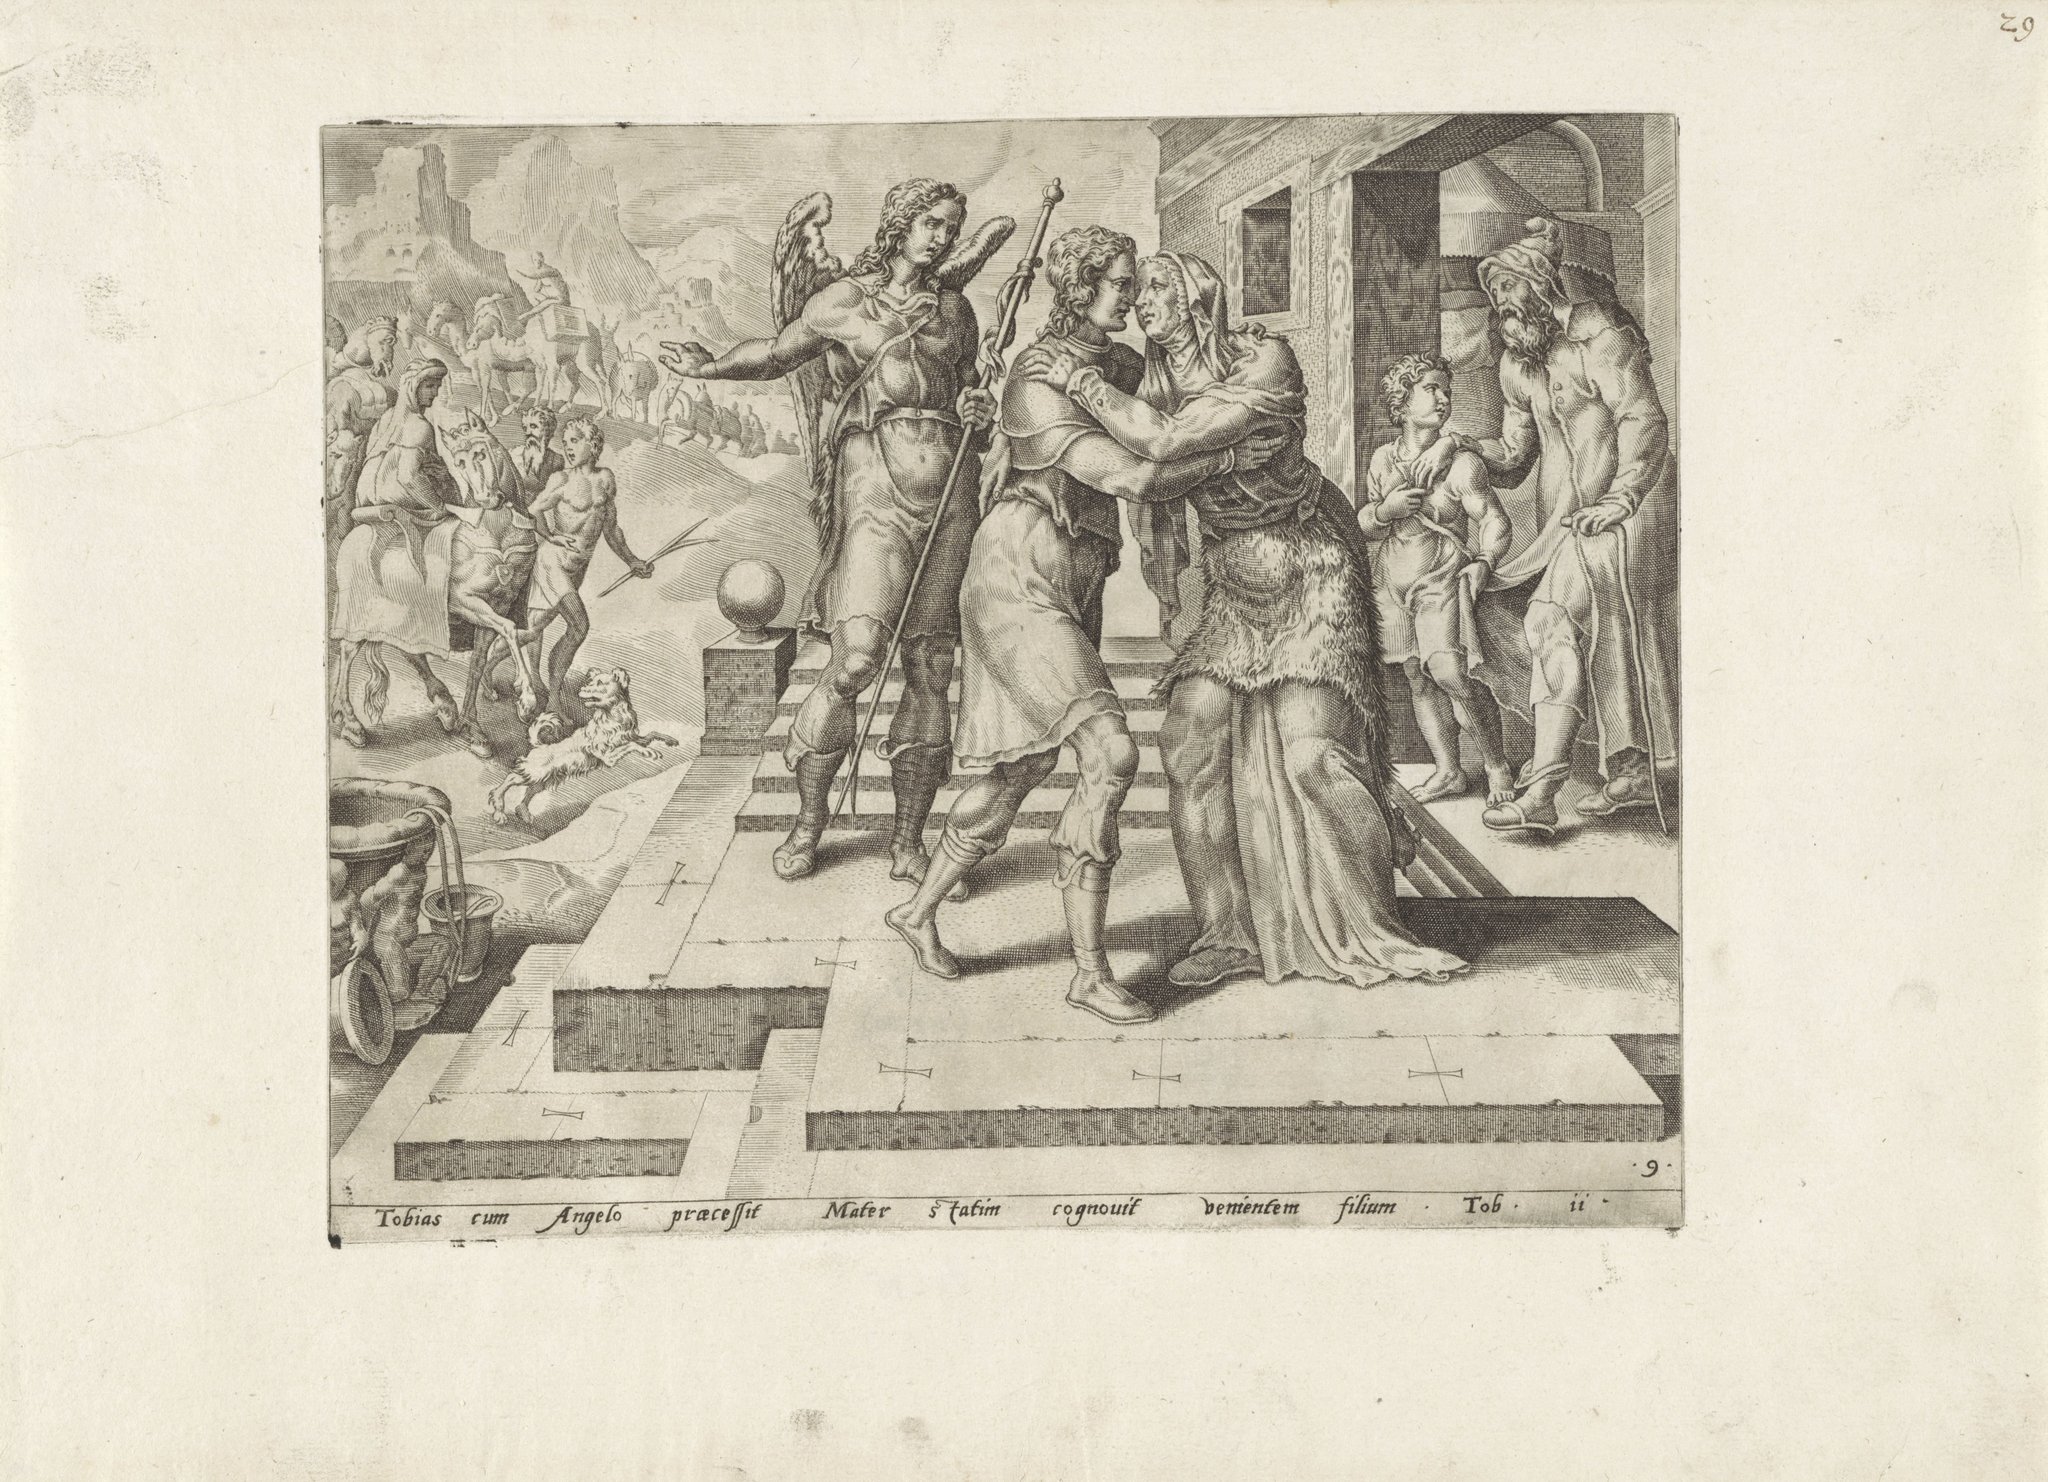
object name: print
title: Terugkeer van Tobias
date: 1556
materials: paper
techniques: engraving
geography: low countries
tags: the meeting of parents and son ~ tobias' return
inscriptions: number: ‘29’, collector's mark: Lugt 2760, collector's mark: Lugt 2228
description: Tobias omhelst zijn moeder Anna bij thuiskomst. Achter haar leidt een jongen de blinde Tobit naar buiten. De aartsengel Rafaël wijst in de richting van Sara en de met geschenken bepakte dieren. Onderaan in de marge een éénregelig onderschrift in het Latijn uit Tobit 11.